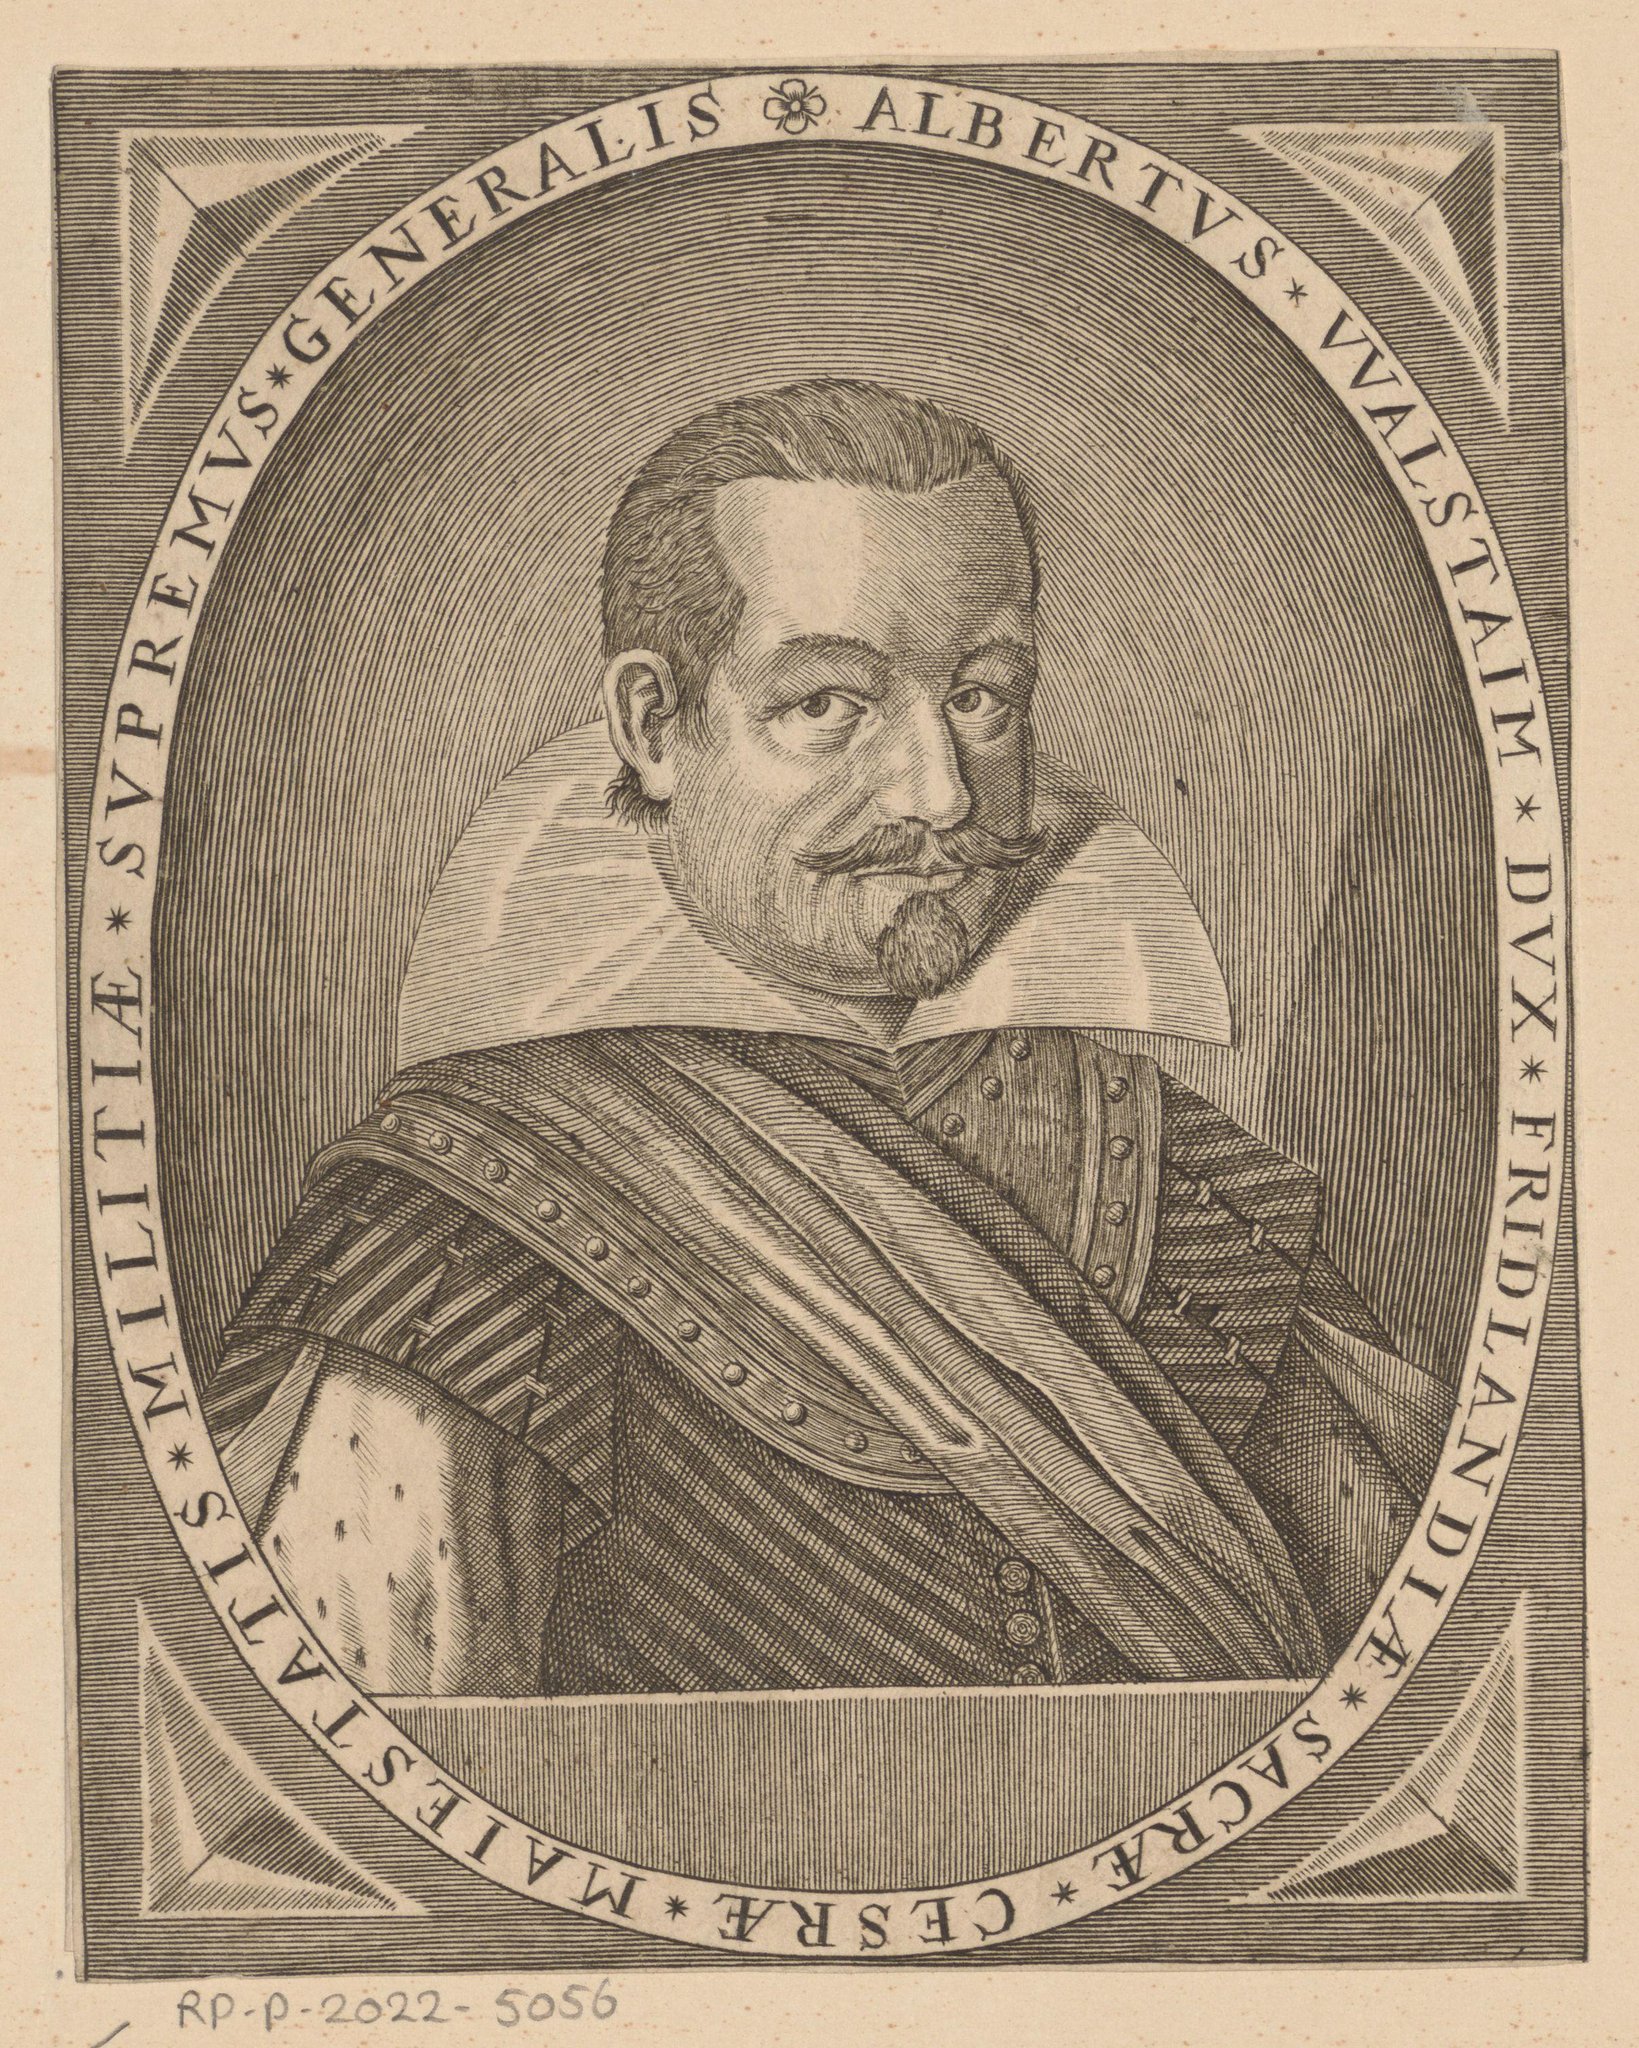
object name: print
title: Portret van Albrecht von Wallenstein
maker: Anonymous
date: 1643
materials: paper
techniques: engraving, etching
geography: italy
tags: commander-in-chief, general, marshal, historical persons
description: Prent met tekst op verso gebruikt in: Priorato, Geleazzo Gualdo. Historia della vita d'Alberto Valstain duca di Fritland (...). Lyon: Jean-Ayme Candy, 1643.